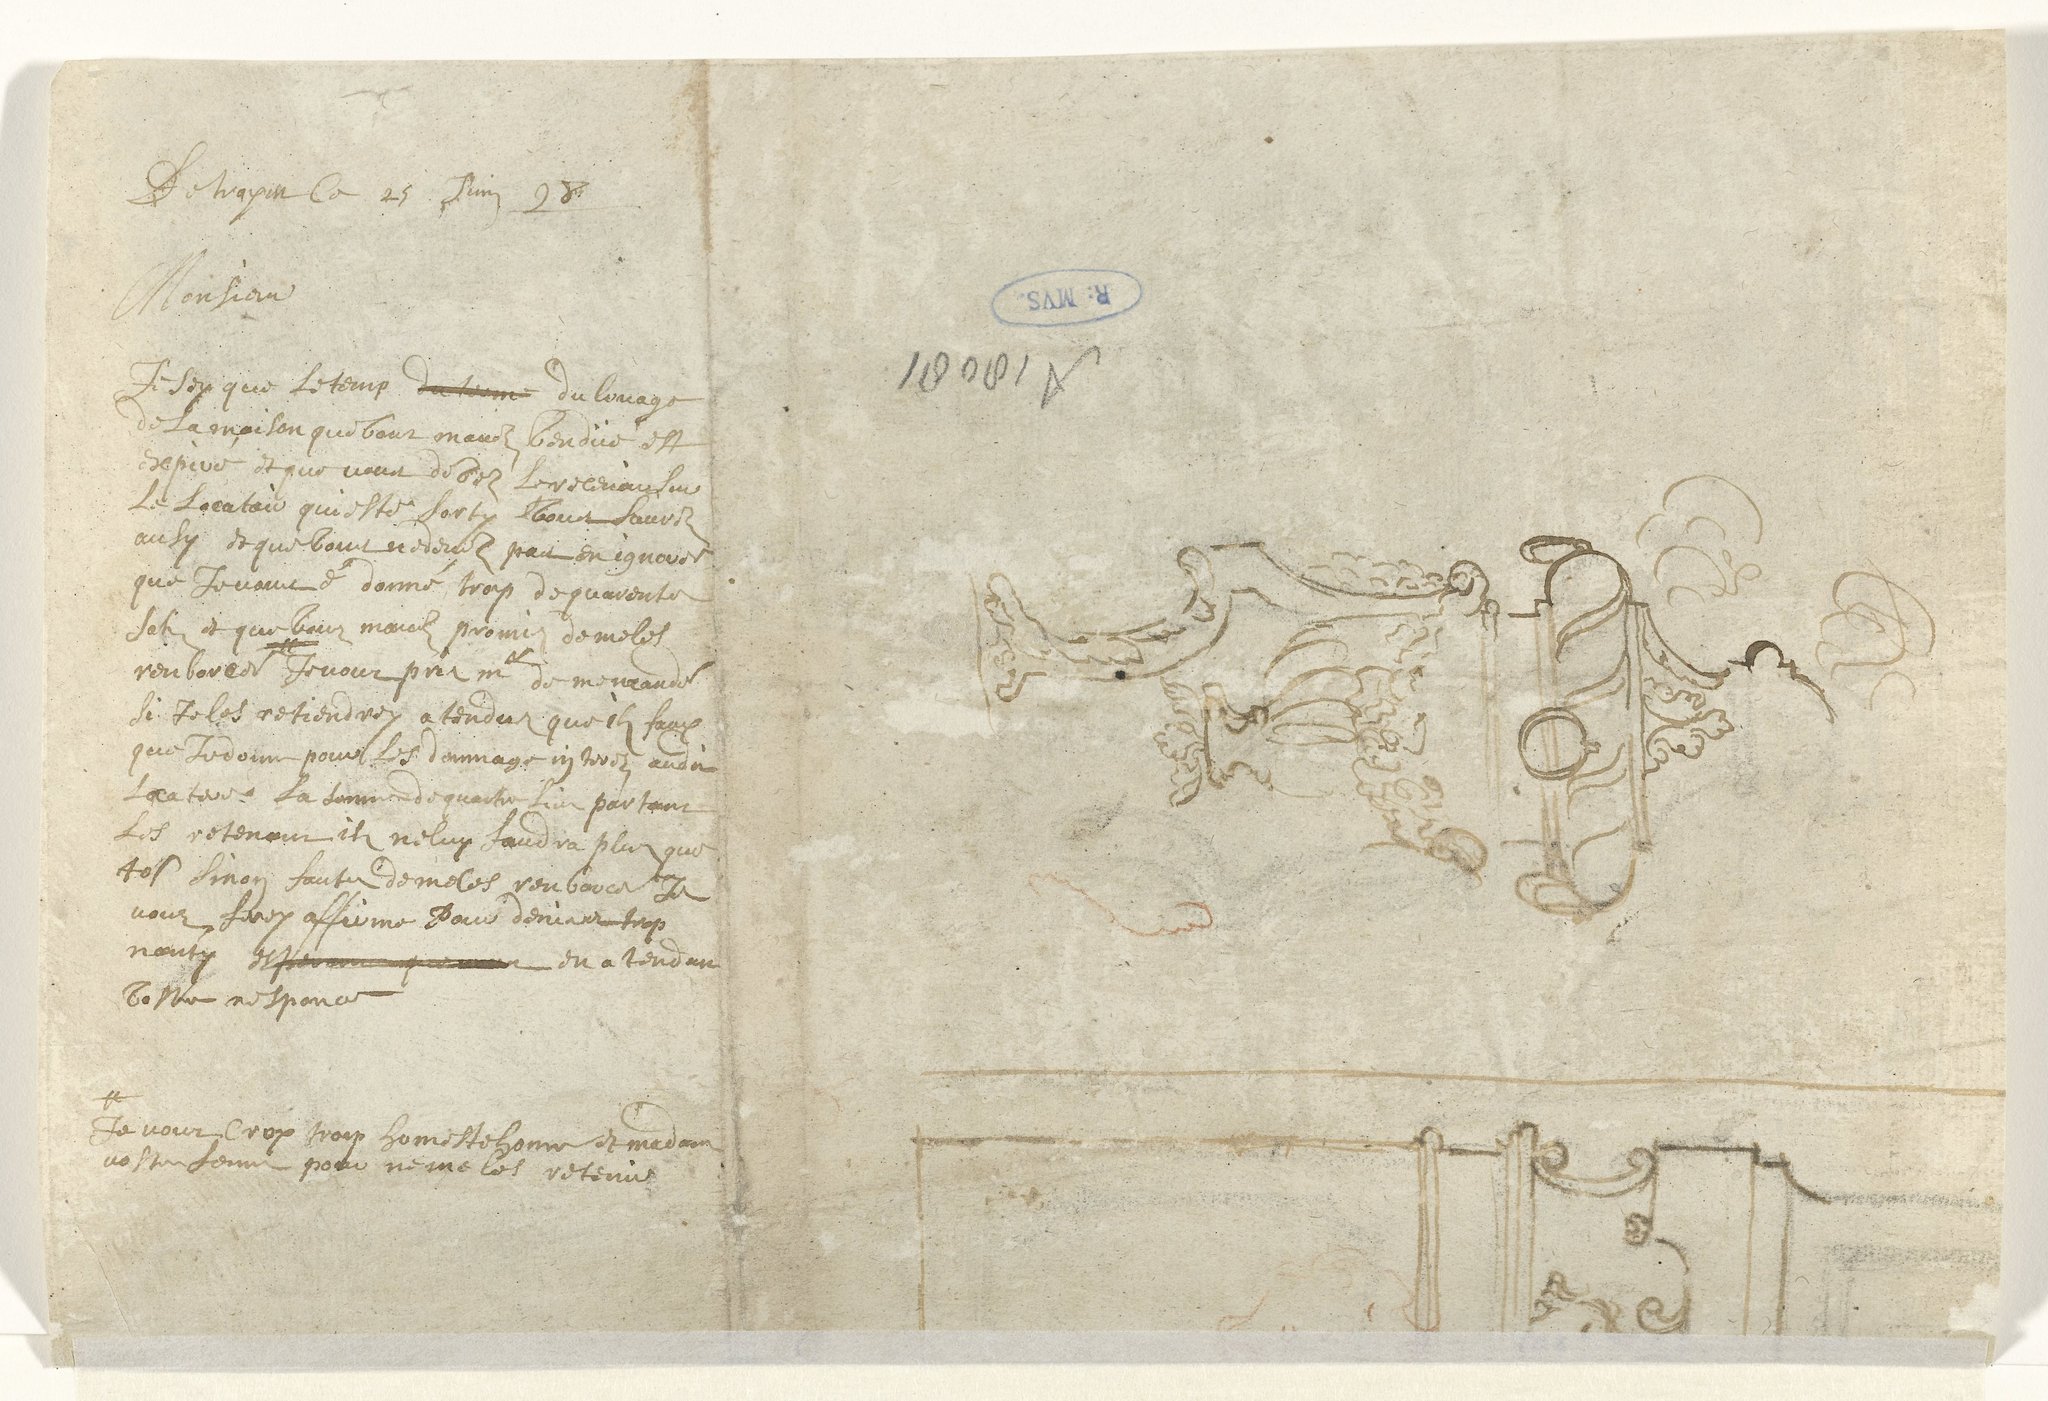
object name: letter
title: Handgeschreven tekst en twee schetsen van een zuil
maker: Anonymous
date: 1728-1828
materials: paper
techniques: writing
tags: column, pillar ~ architecture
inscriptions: collector's mark: Lugt 2228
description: Handgeschreven brief in het Frans met plaats en datum Antwerpen(?) le 25 Juni 28 en beginnend met Monsieur. Daarnaast twee schetsen van twee onderling verschillende zuilen.